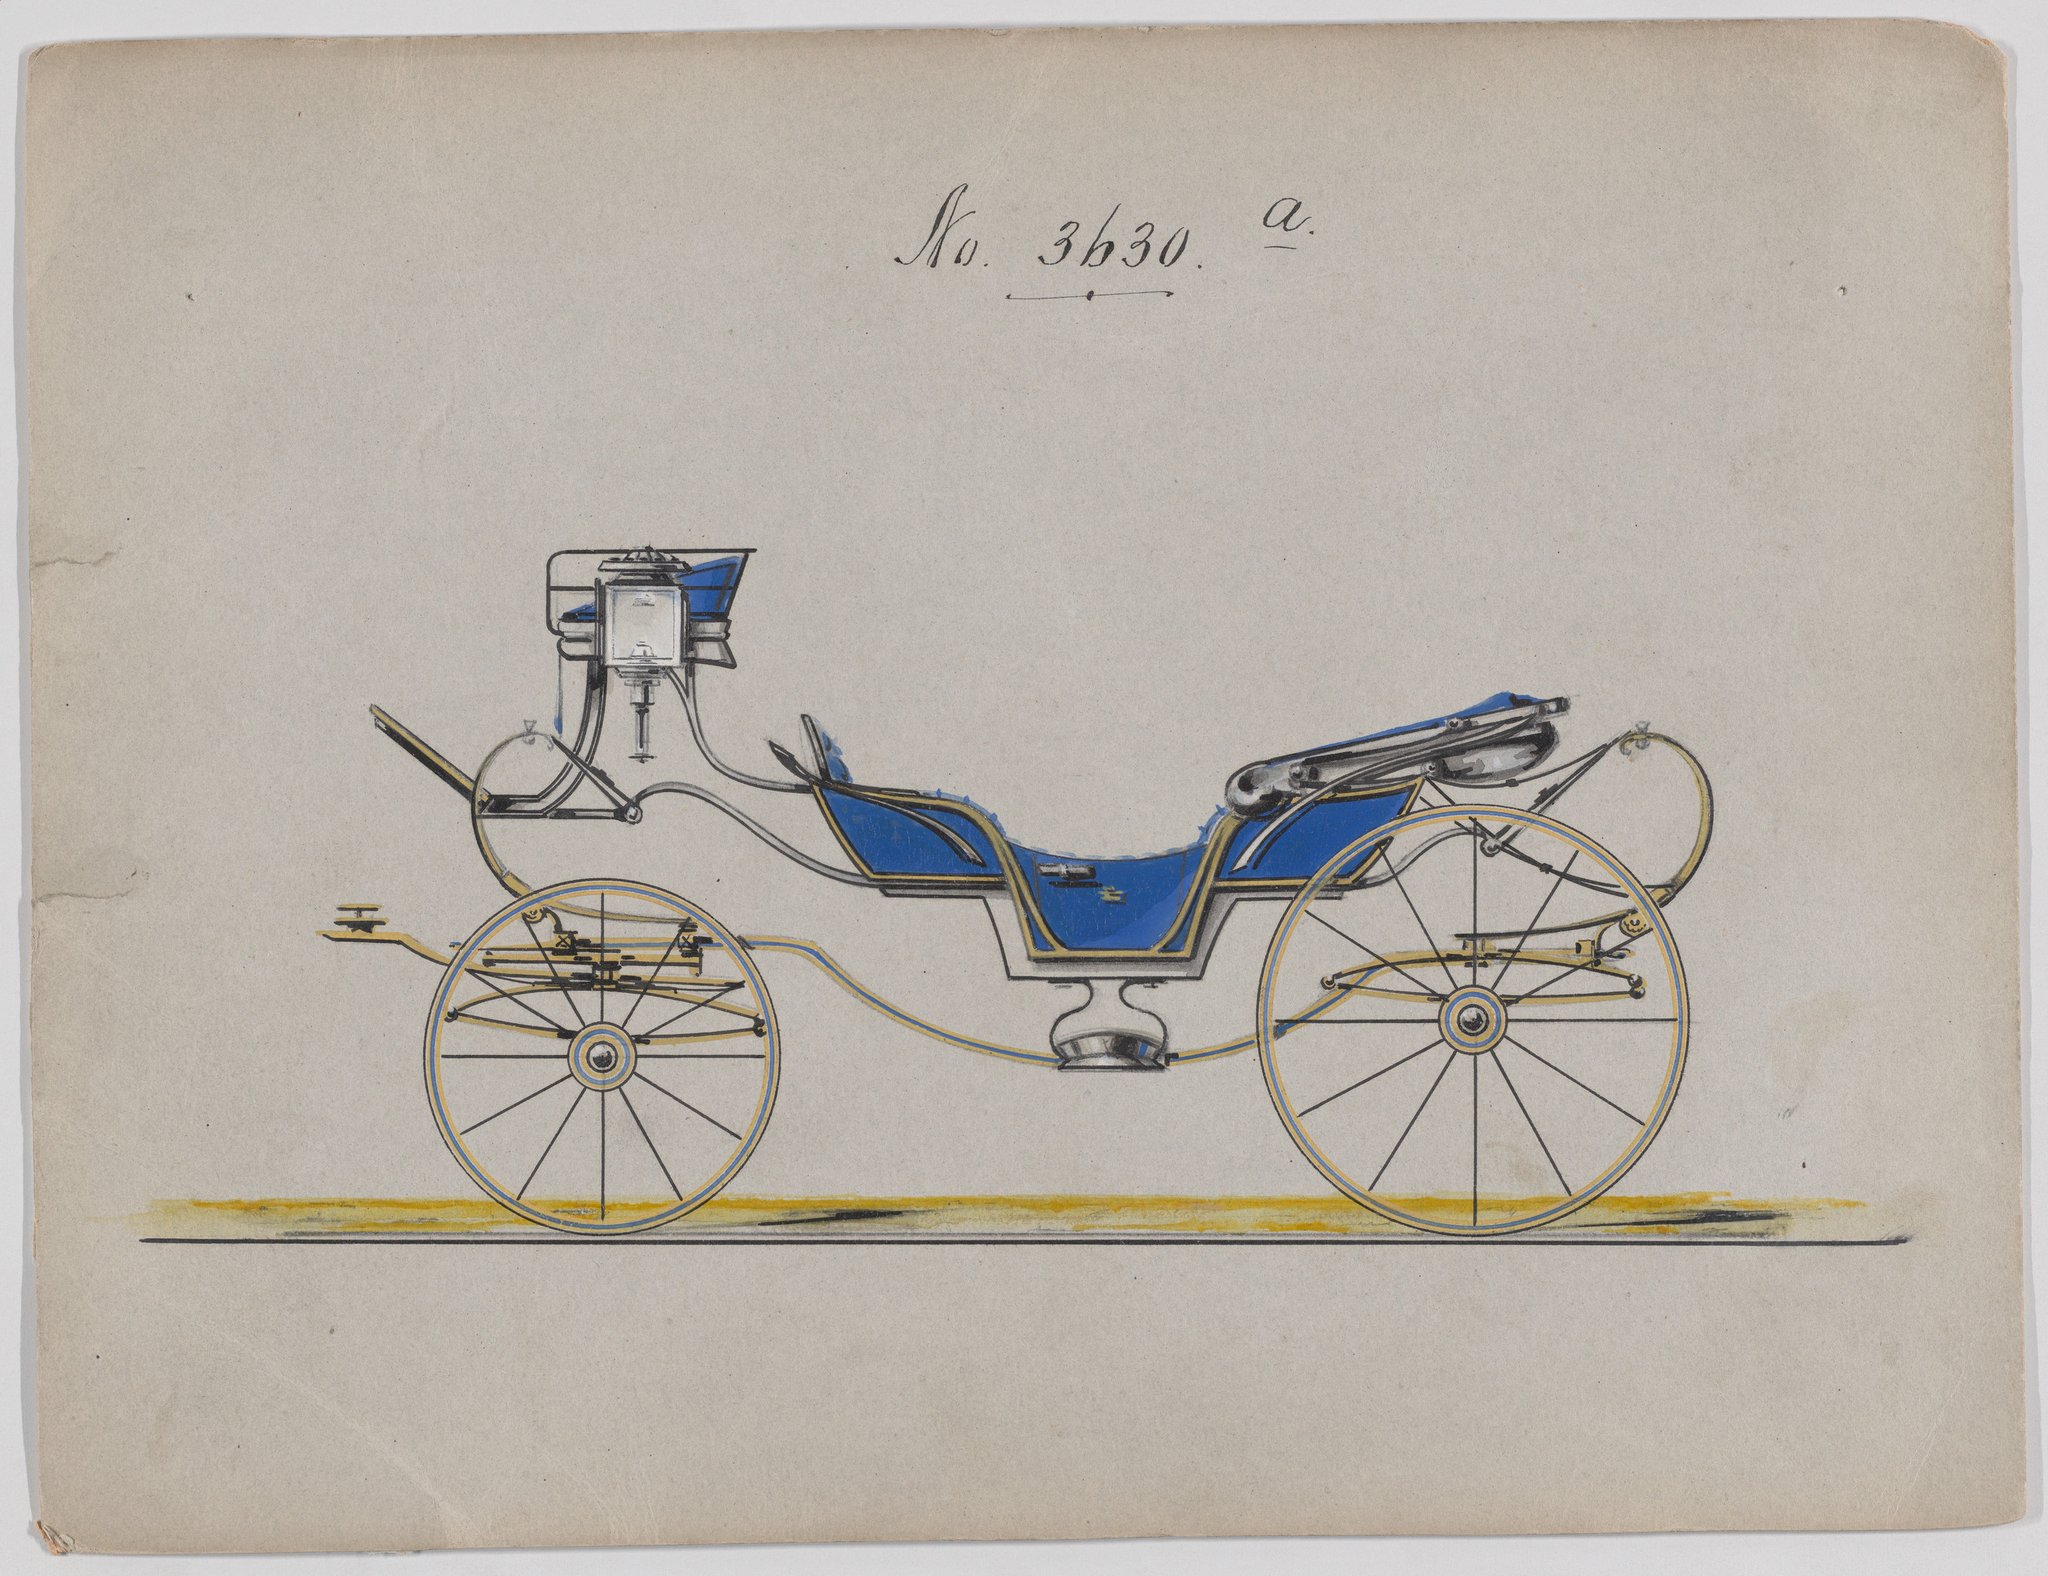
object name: drawing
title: Vis-a-Vis/ Caleche #3630a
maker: brewster & co.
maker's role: manufacturer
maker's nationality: american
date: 1880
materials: gouache, ink, watercolor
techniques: pen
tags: carriages